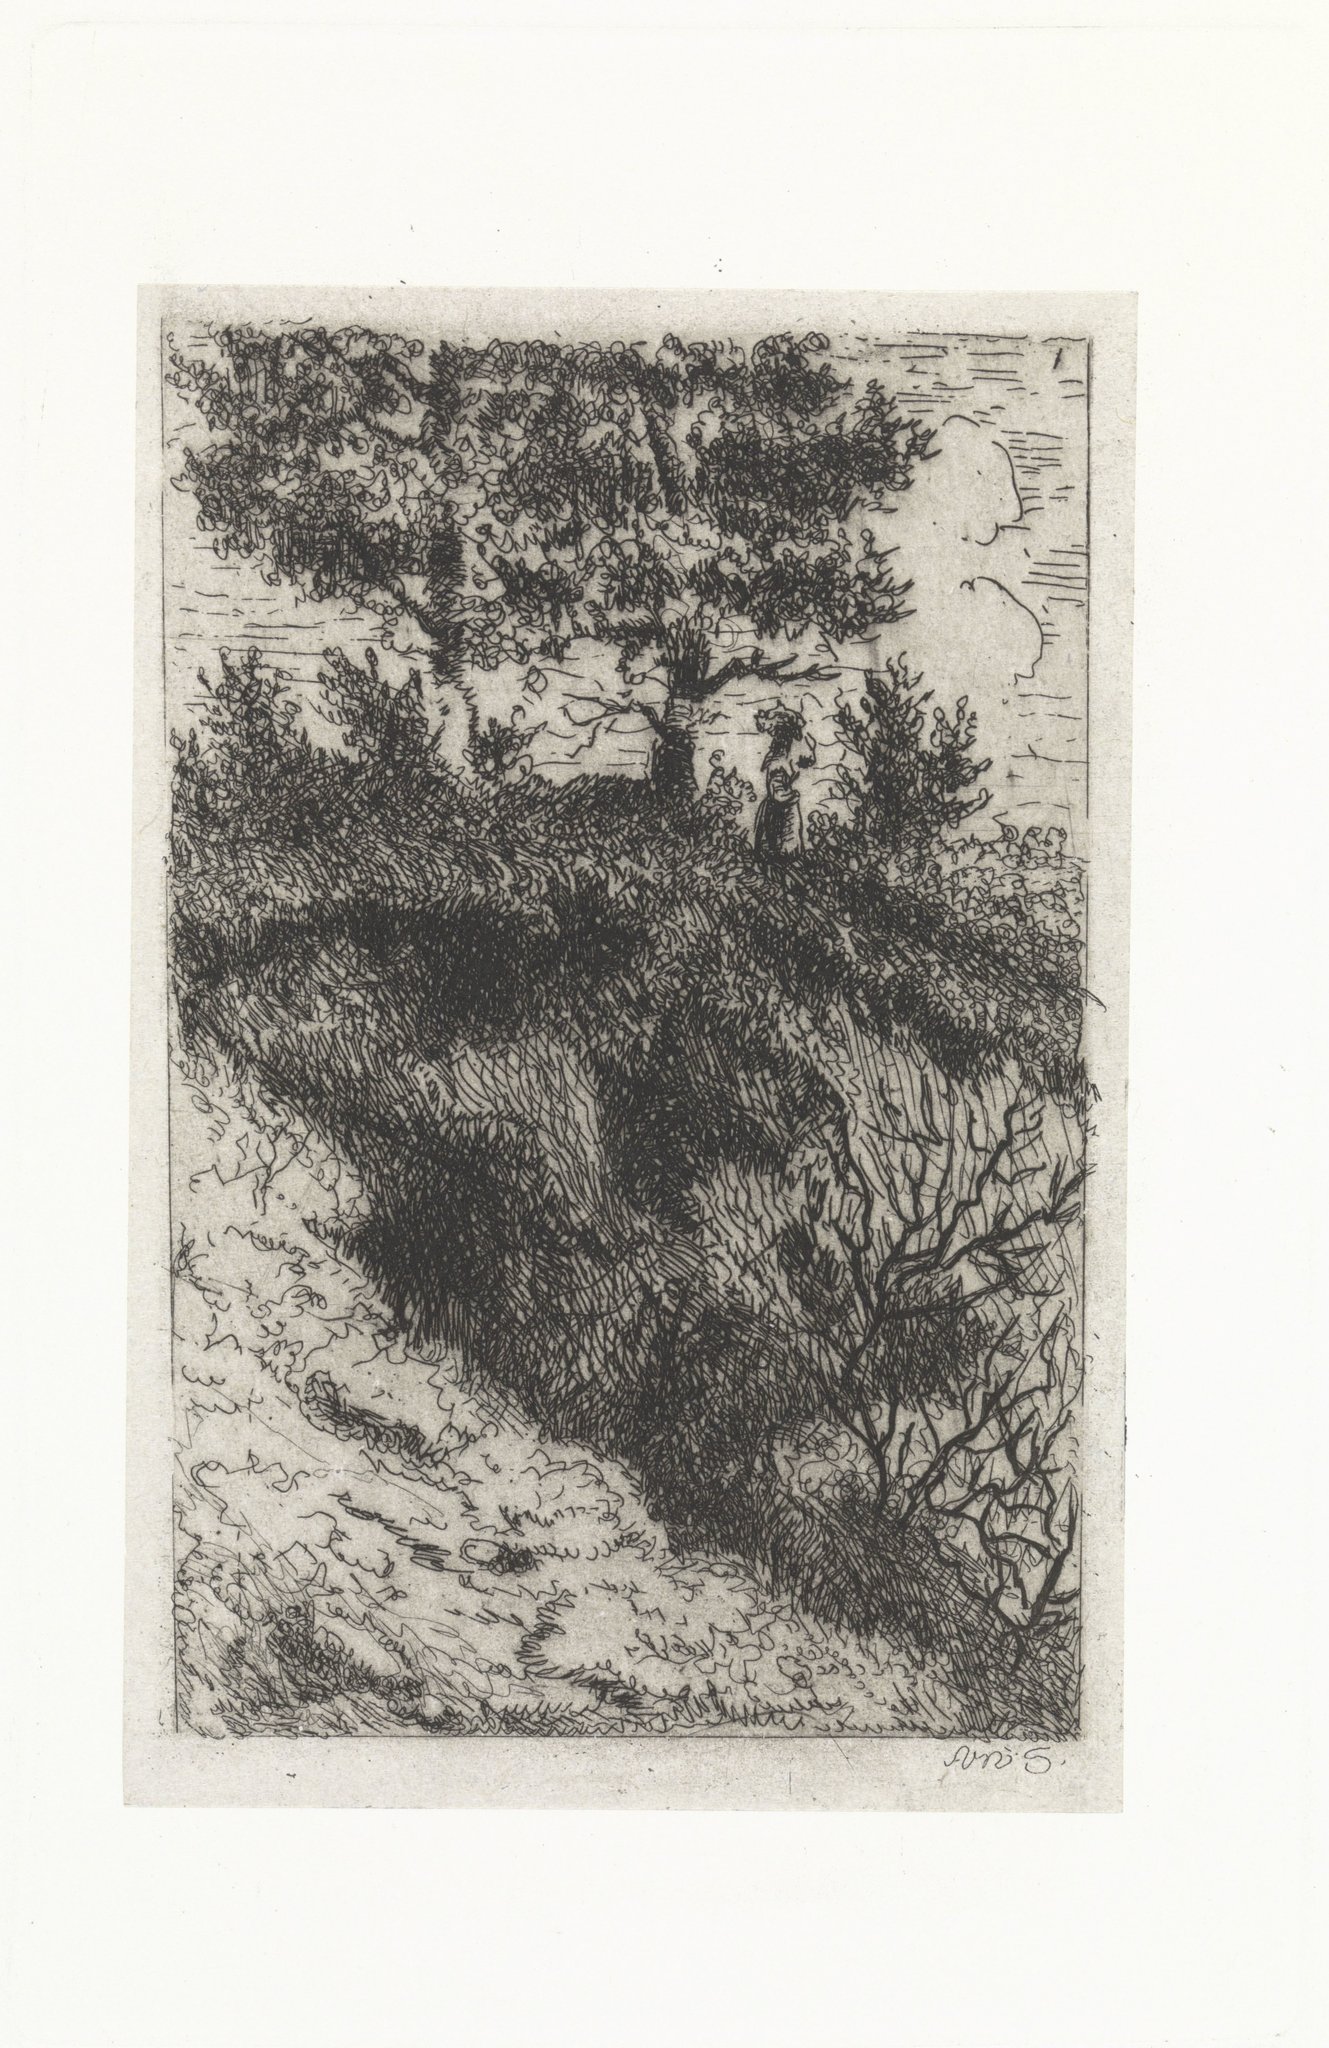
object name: print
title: Vrouw in een duinlandschap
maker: arnoud schaepkens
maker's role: print maker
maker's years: 1816-1904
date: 1831-1888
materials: paper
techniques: drypoint, etching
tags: dunes (sea not visible); in the dunes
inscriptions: collector's mark: Lugt 2228